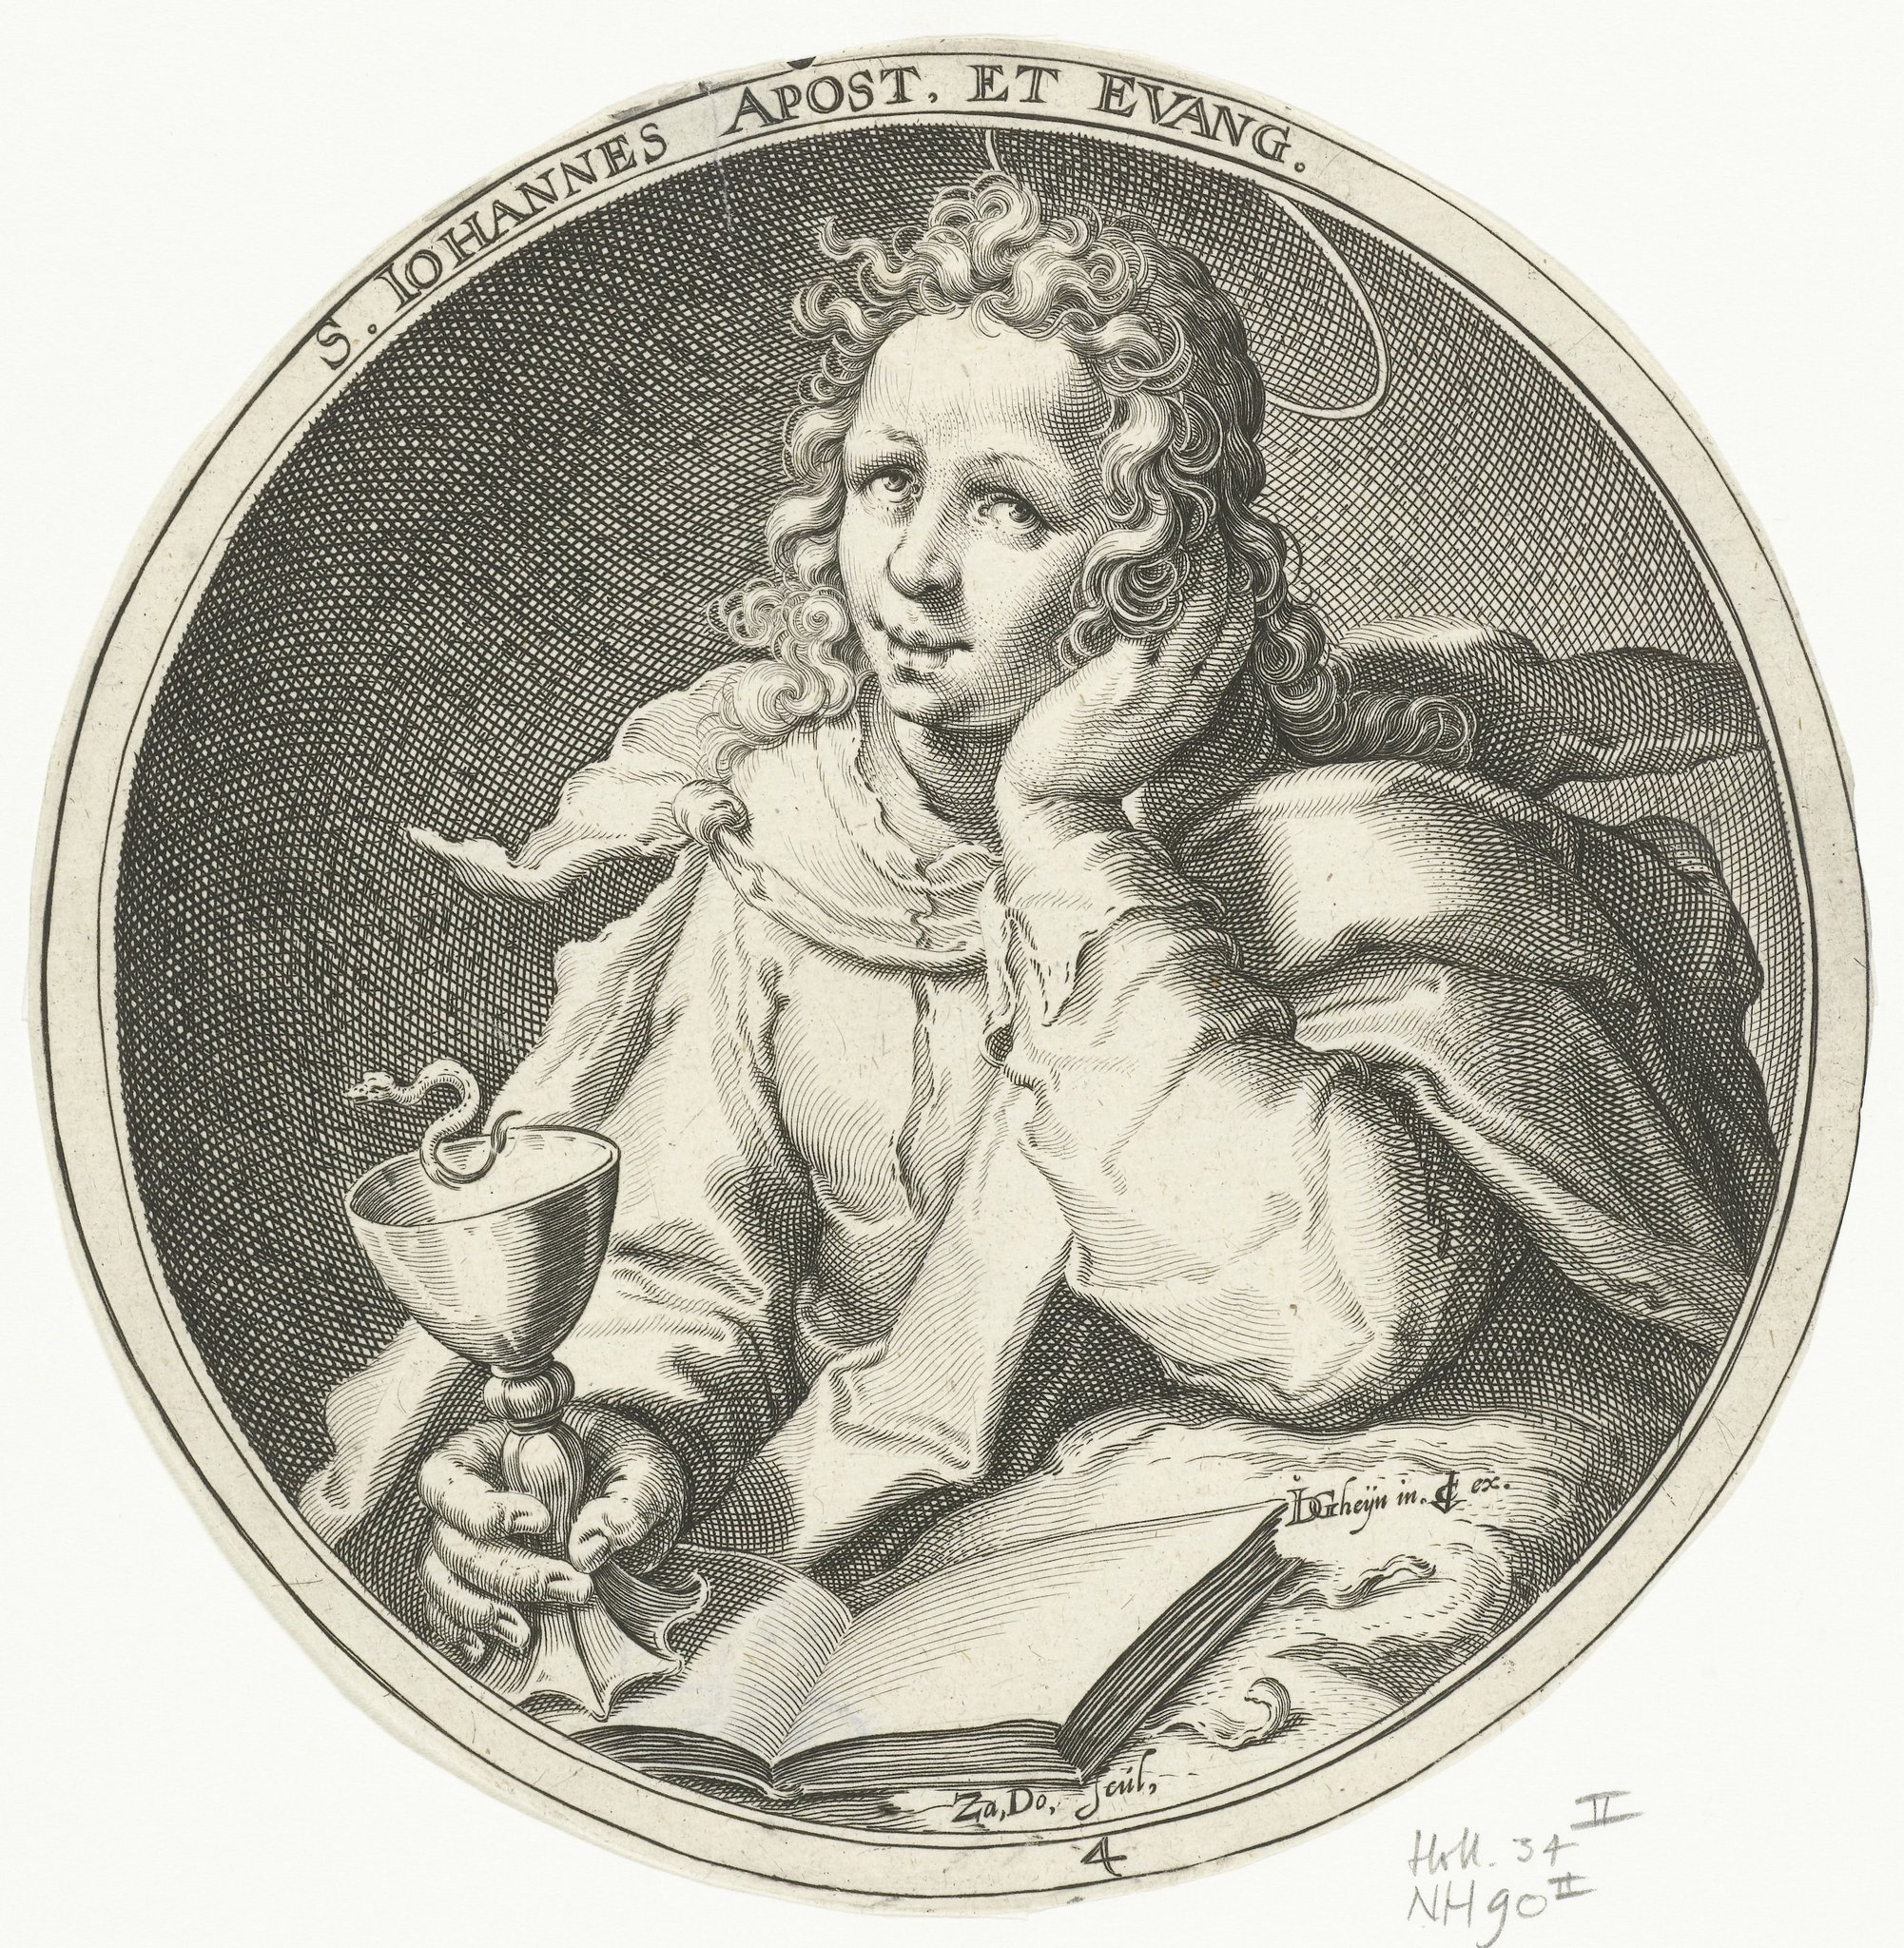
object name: print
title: Christus, de apostelen en de H. Paulus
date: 1609-1652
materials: paper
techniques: engraving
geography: amsterdam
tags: the apostle john the evangelist; possible attributes: book, cauldron, chalice with snake, eagle, palm, scroll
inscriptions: collector's mark: Lugt 2228